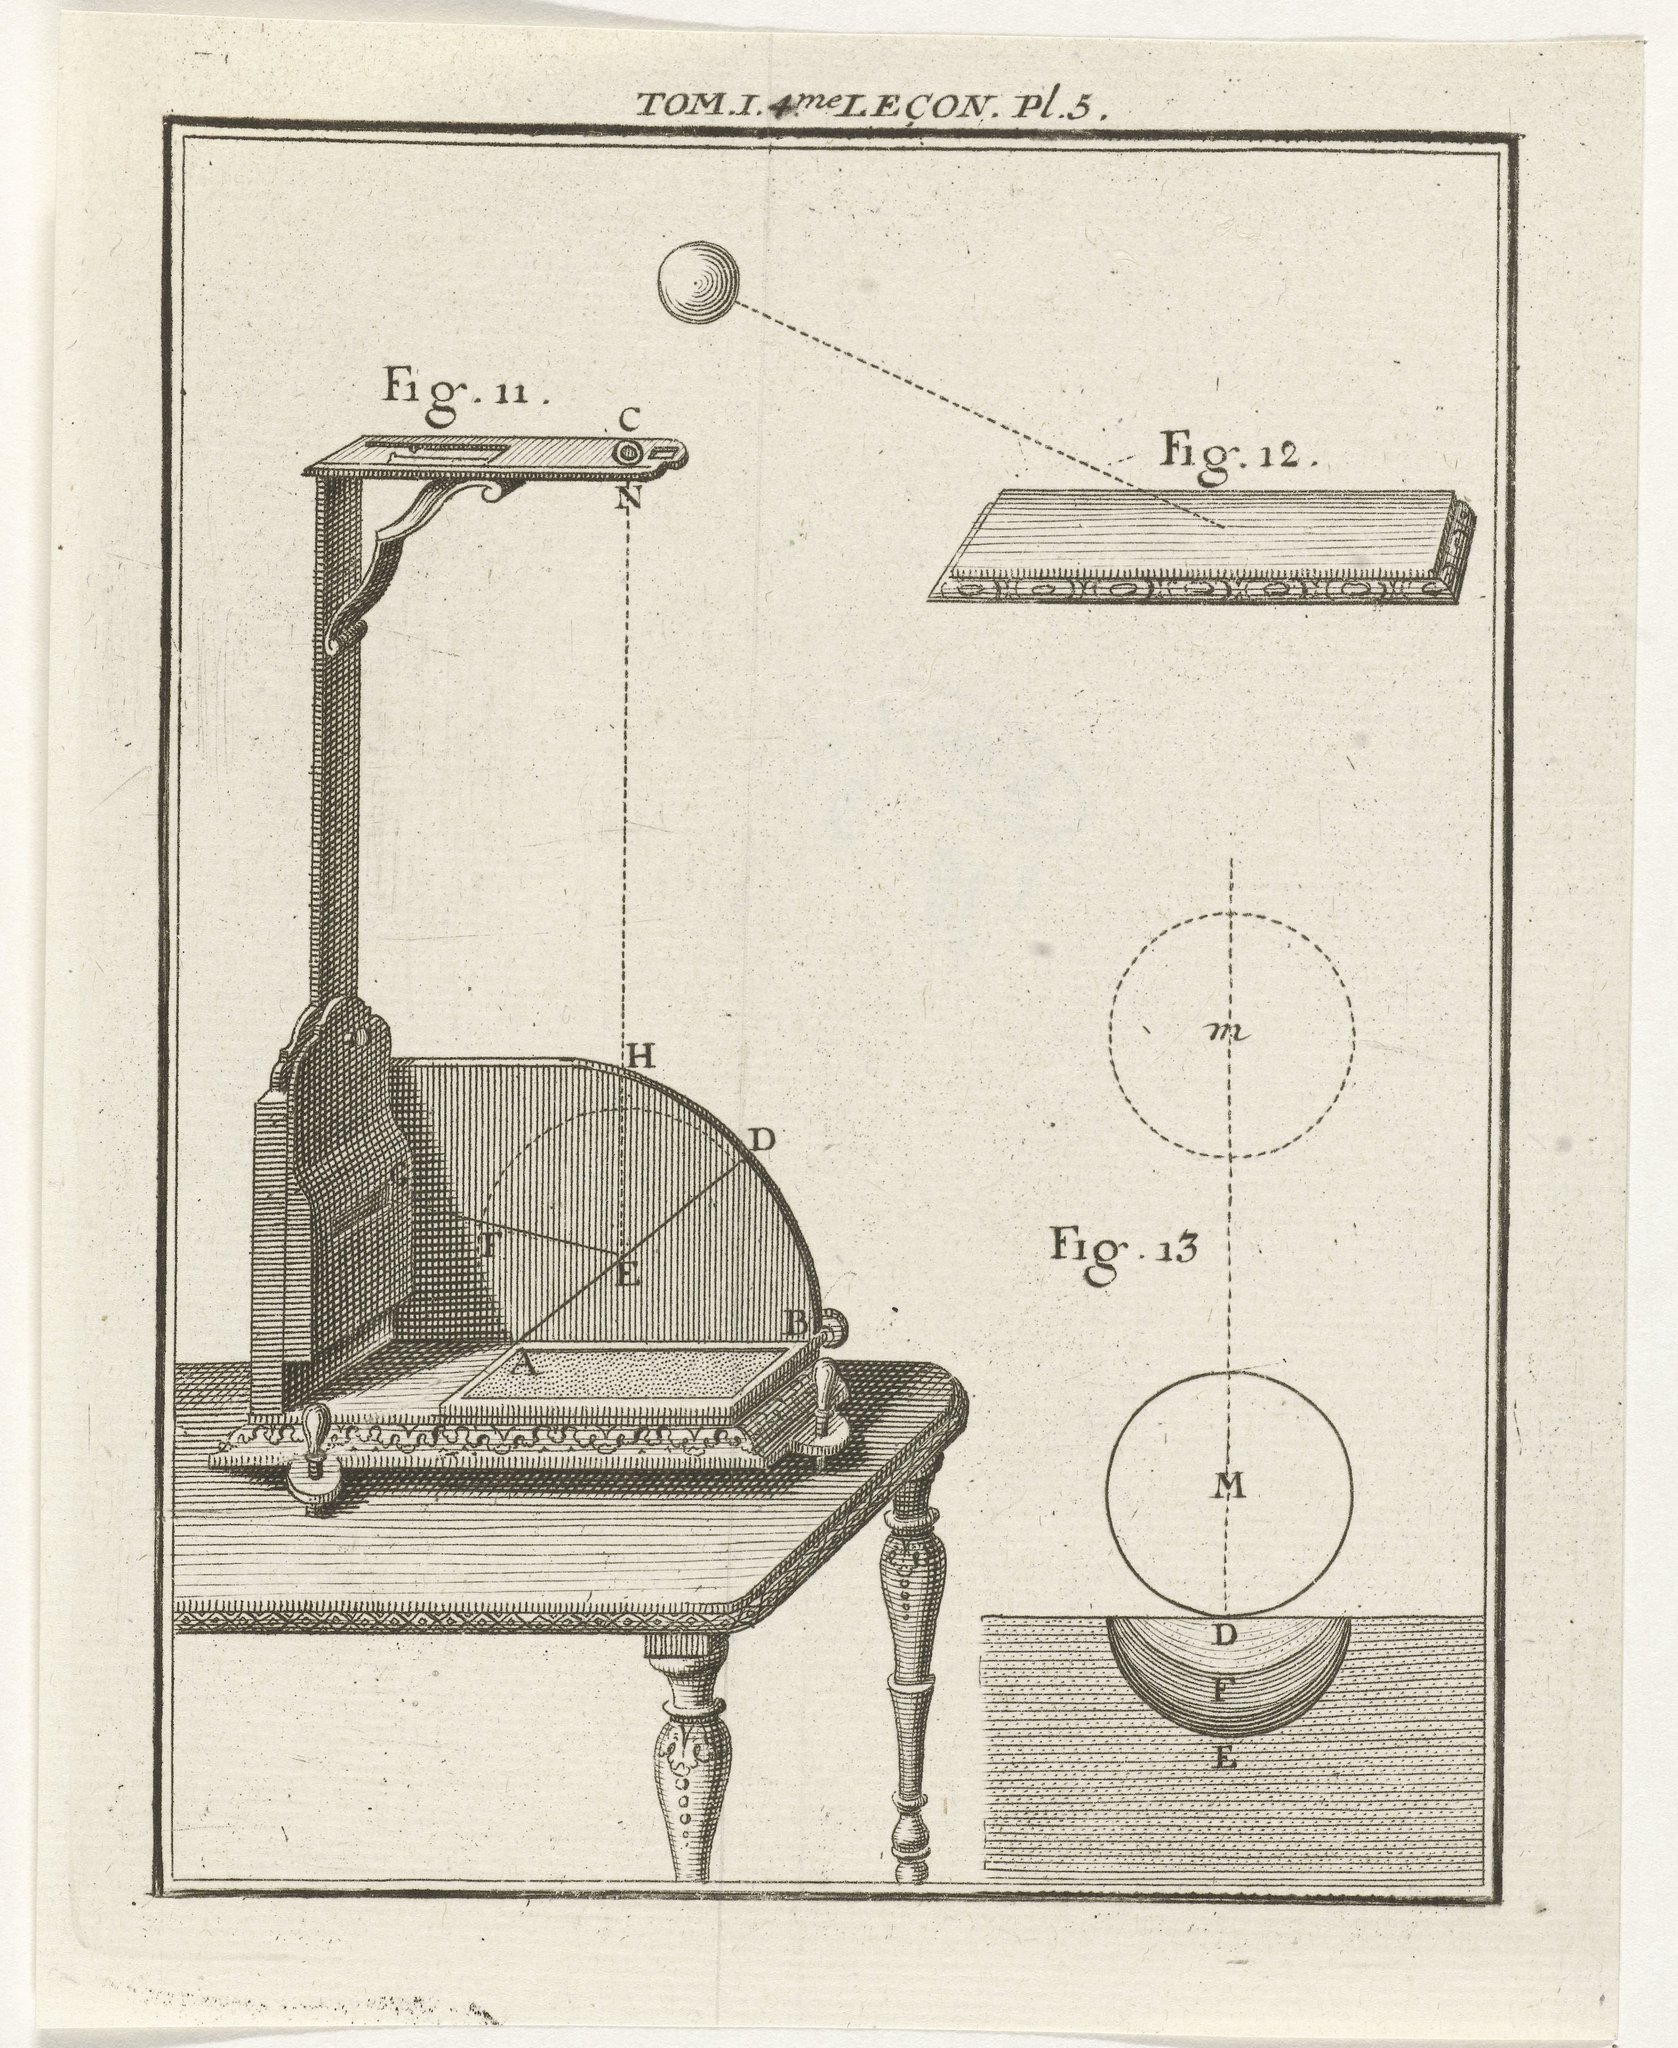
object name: book illustration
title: Natuurkundige instrumenten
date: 1759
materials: paper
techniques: etching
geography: amsterdam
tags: physics (+ tools, instruments; laboratory equipment ~ scientific research)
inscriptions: collector's mark: Lugt 2228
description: Weergave van instrumenten en modellen voor natuurkundig onderzoek, voorzien van nummers en letters. Prent middenboven gemerkt: Tom. I.4me Leçon. Pl. 5.